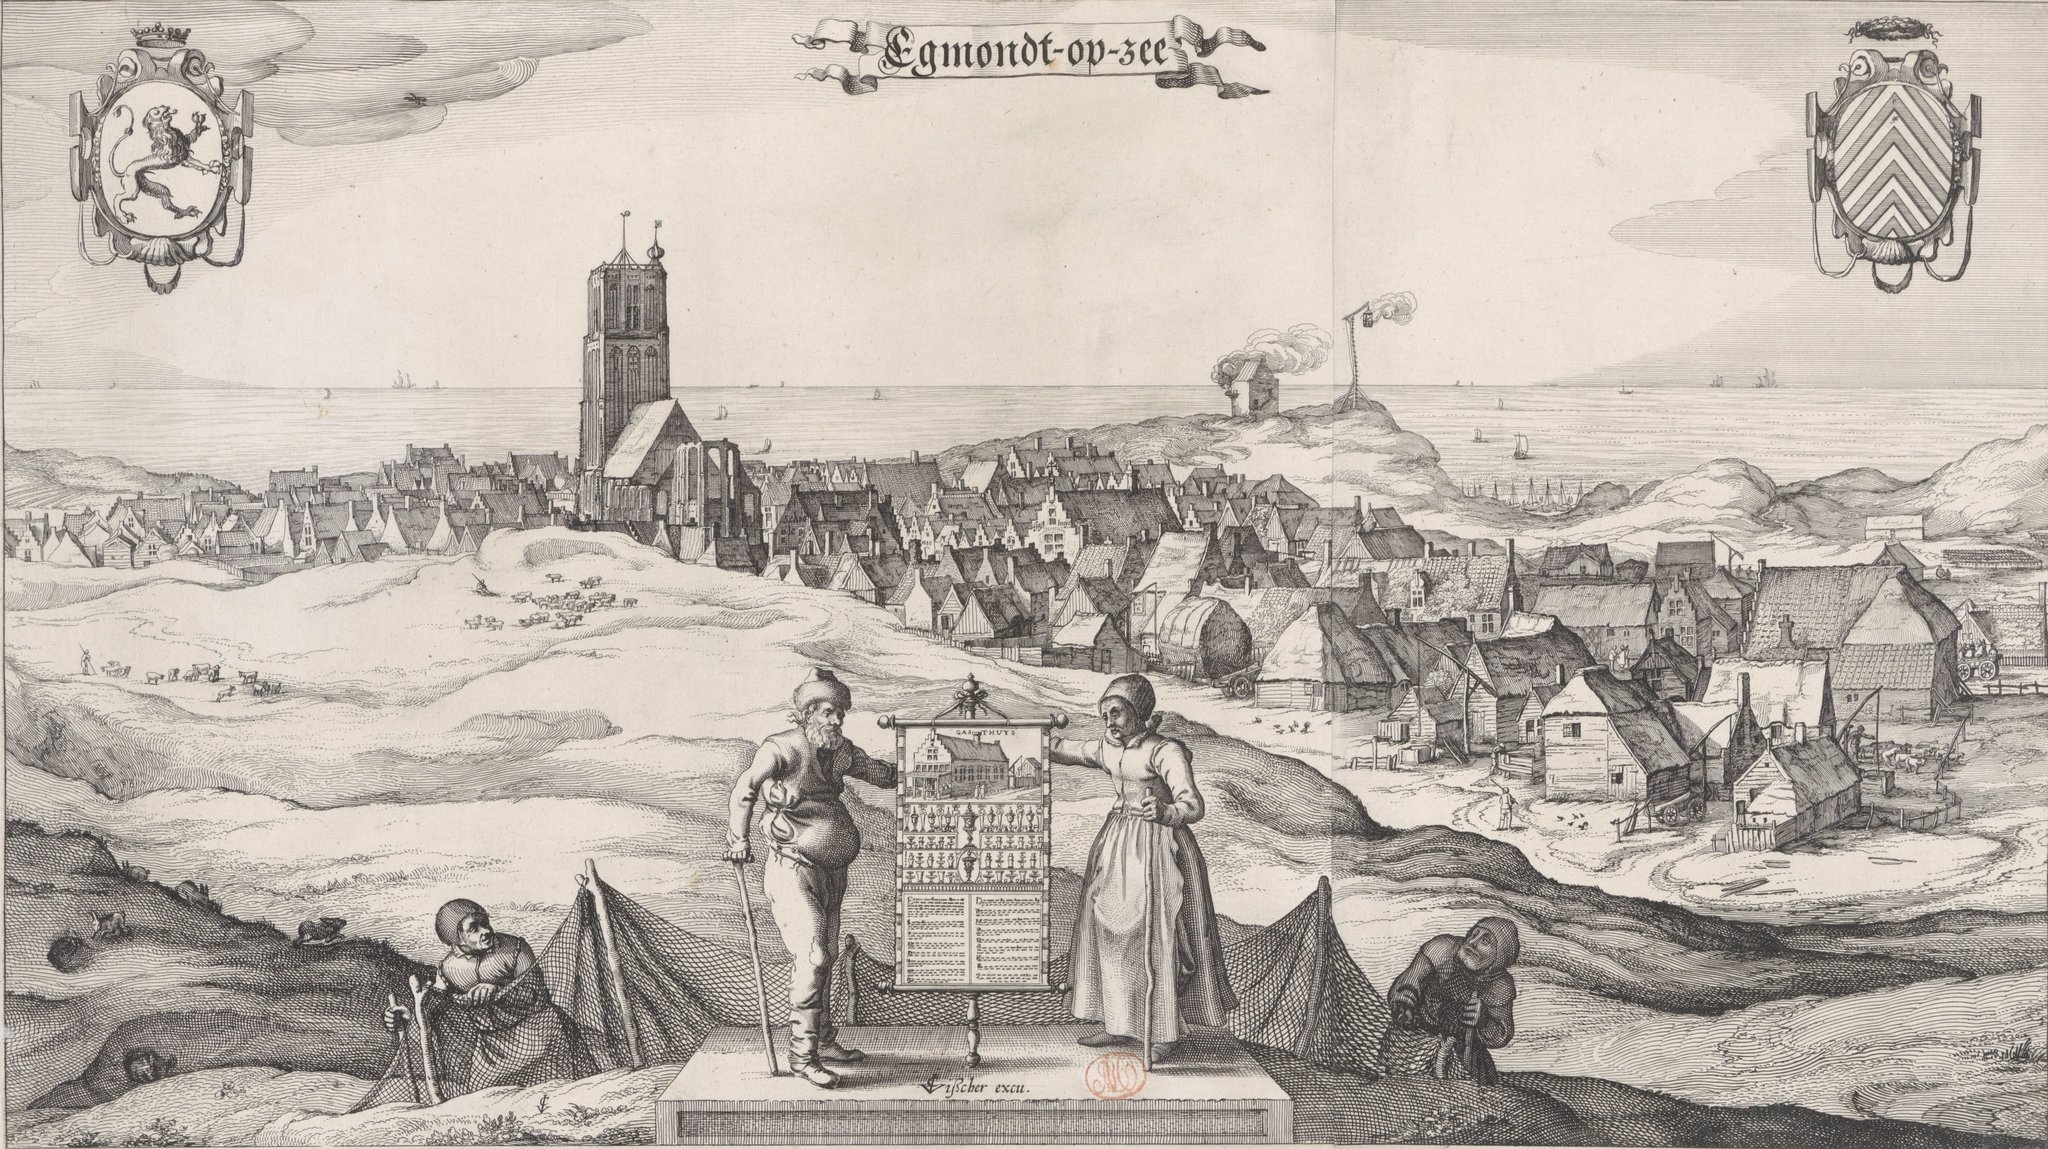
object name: loterijprent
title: Gezicht op Egmond aan Zee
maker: claes jansz. visscher (ii)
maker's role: draughtsman, print maker, publisher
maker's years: 1586-1652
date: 1615-1618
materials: paper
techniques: engraving, etching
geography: amsterdam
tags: raffle, lottery, herding, herdsman, herdswoman, shepherd, shepherdess, cowherd, etc.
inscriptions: collector's mark: Lugt 195, collector's mark: Lugt 2228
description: De loterij te Egmond aan Zee ten behoeve van een nieuw gasthuis, ca. 1618. Op de voorgrond een oude man en vrouw die een loterijprent omhoog houden met een afbeelding van het nieuwe gasthuis en de te winnen prijzen en het reglement. Achter hen een visser en een visvrouw met een visnet. Op de achtergrond het dorp aan de kust. Het nog te bouwen gasthuis is al opgenomen en aangeduid in het gezicht op het dorp. Bovenaan een banderol met de naam van het dorp met aan weerszijden de wapens van Holland en van Egmond. Gedrukt van 2 platen.